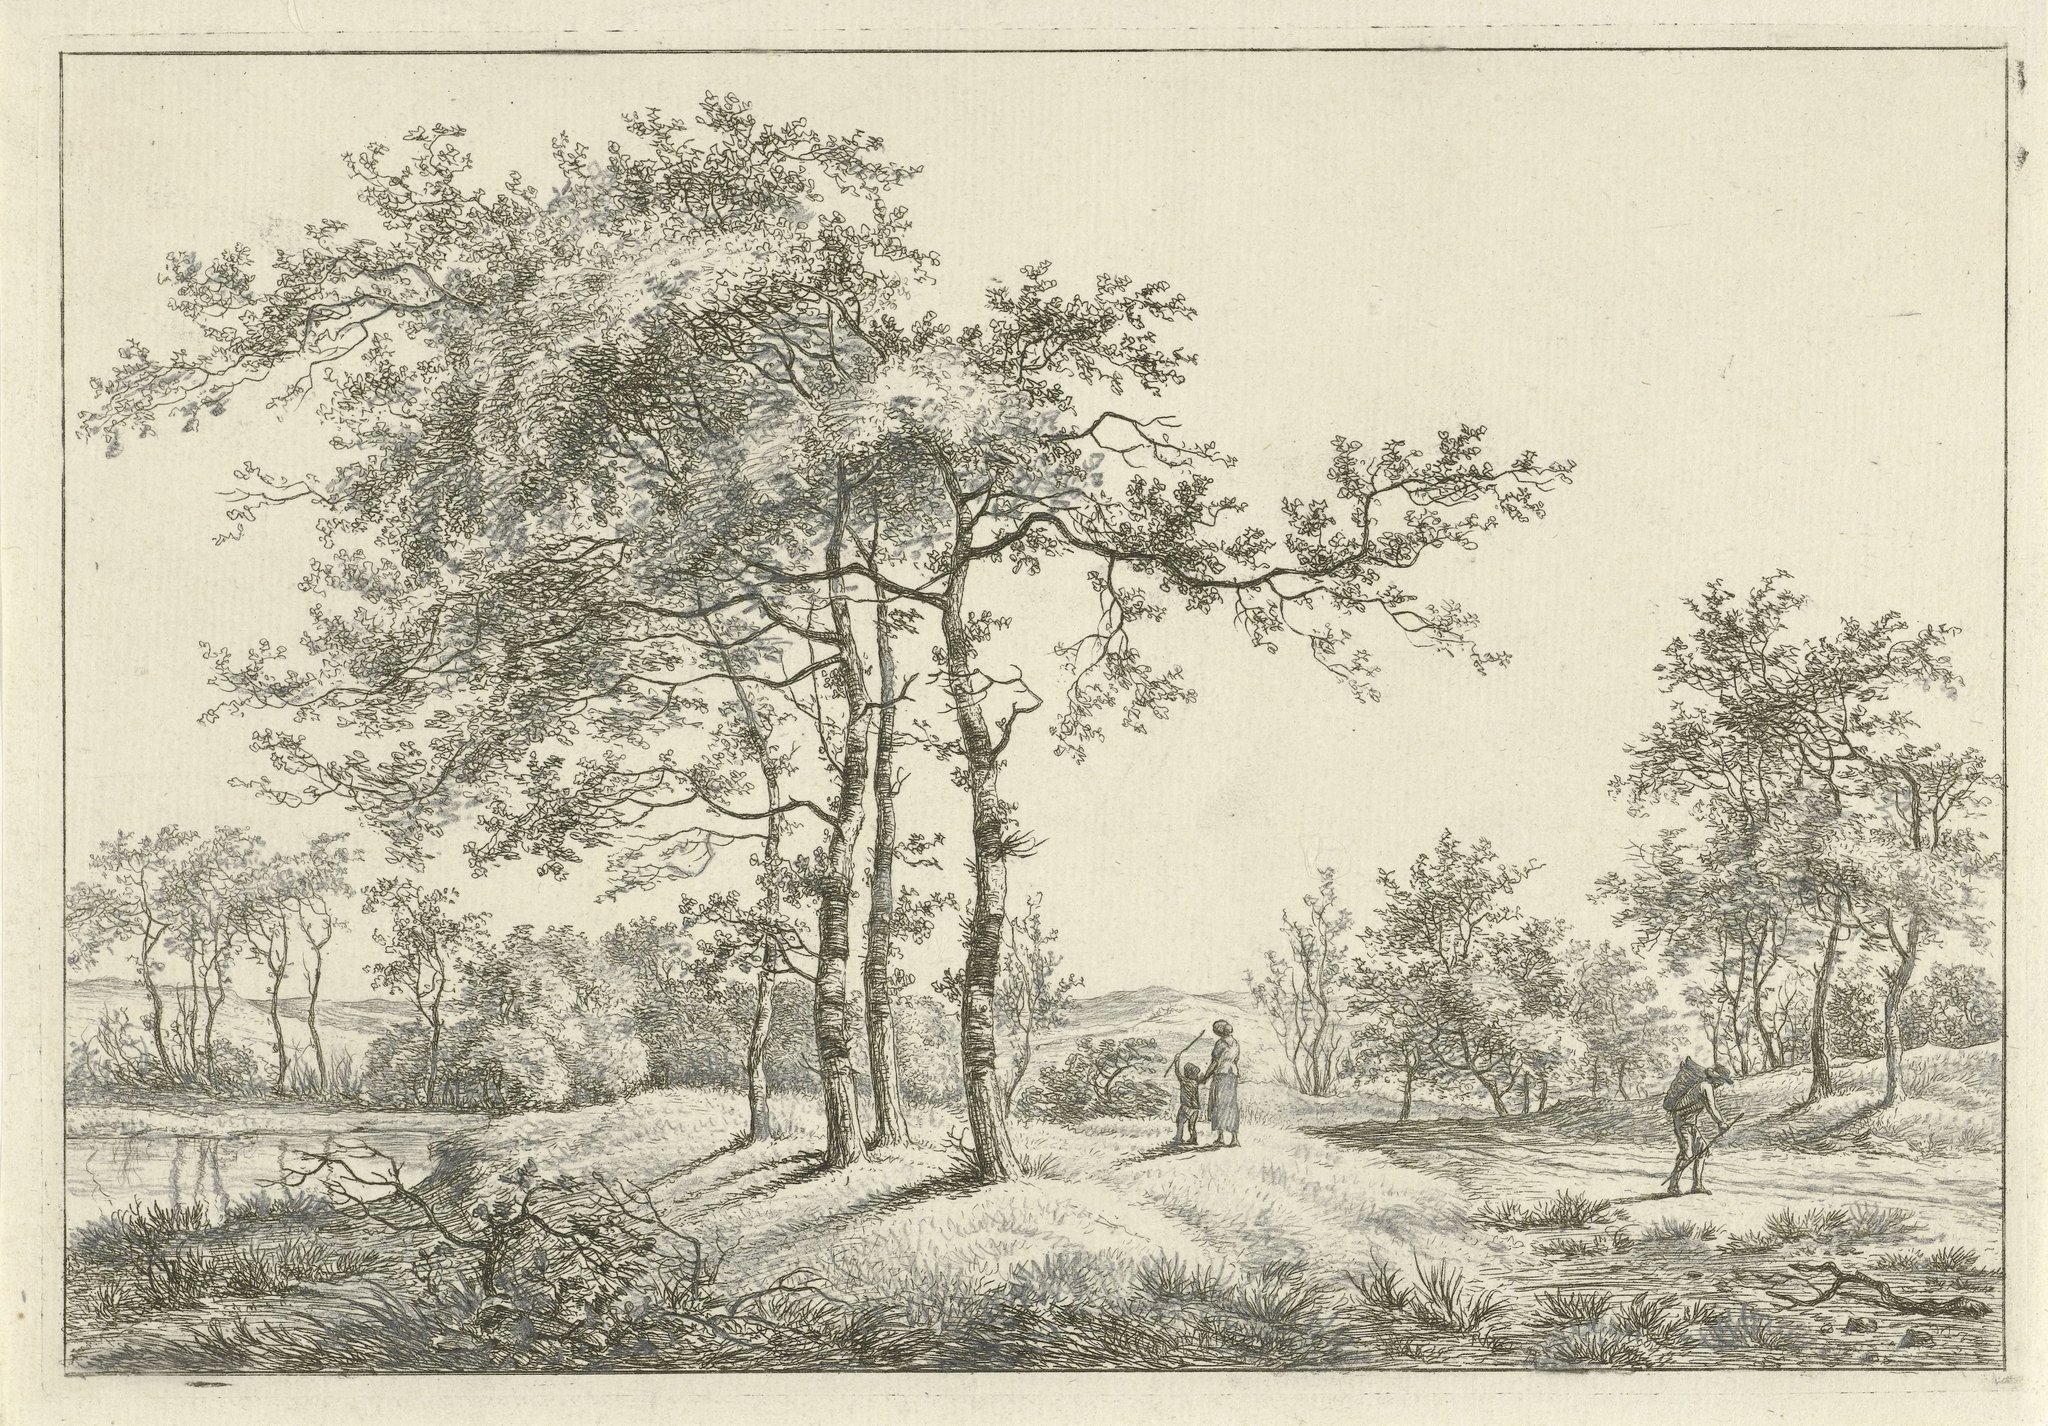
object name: print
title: Landschap met moeder en kind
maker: hermanus fock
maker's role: conservator, draughtsman, painter, print maker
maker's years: 1766-1822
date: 1781-1822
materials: paper, pencil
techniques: etching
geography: amsterdam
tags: landscapes, carrying something in basket, bag, rucksack, etc.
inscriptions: collector's mark: Lugt 2228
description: In een landschap met hoge bomen staan een vrouw en een kind in het gras. Op het pad loopt een man met een mand op zijn rug.